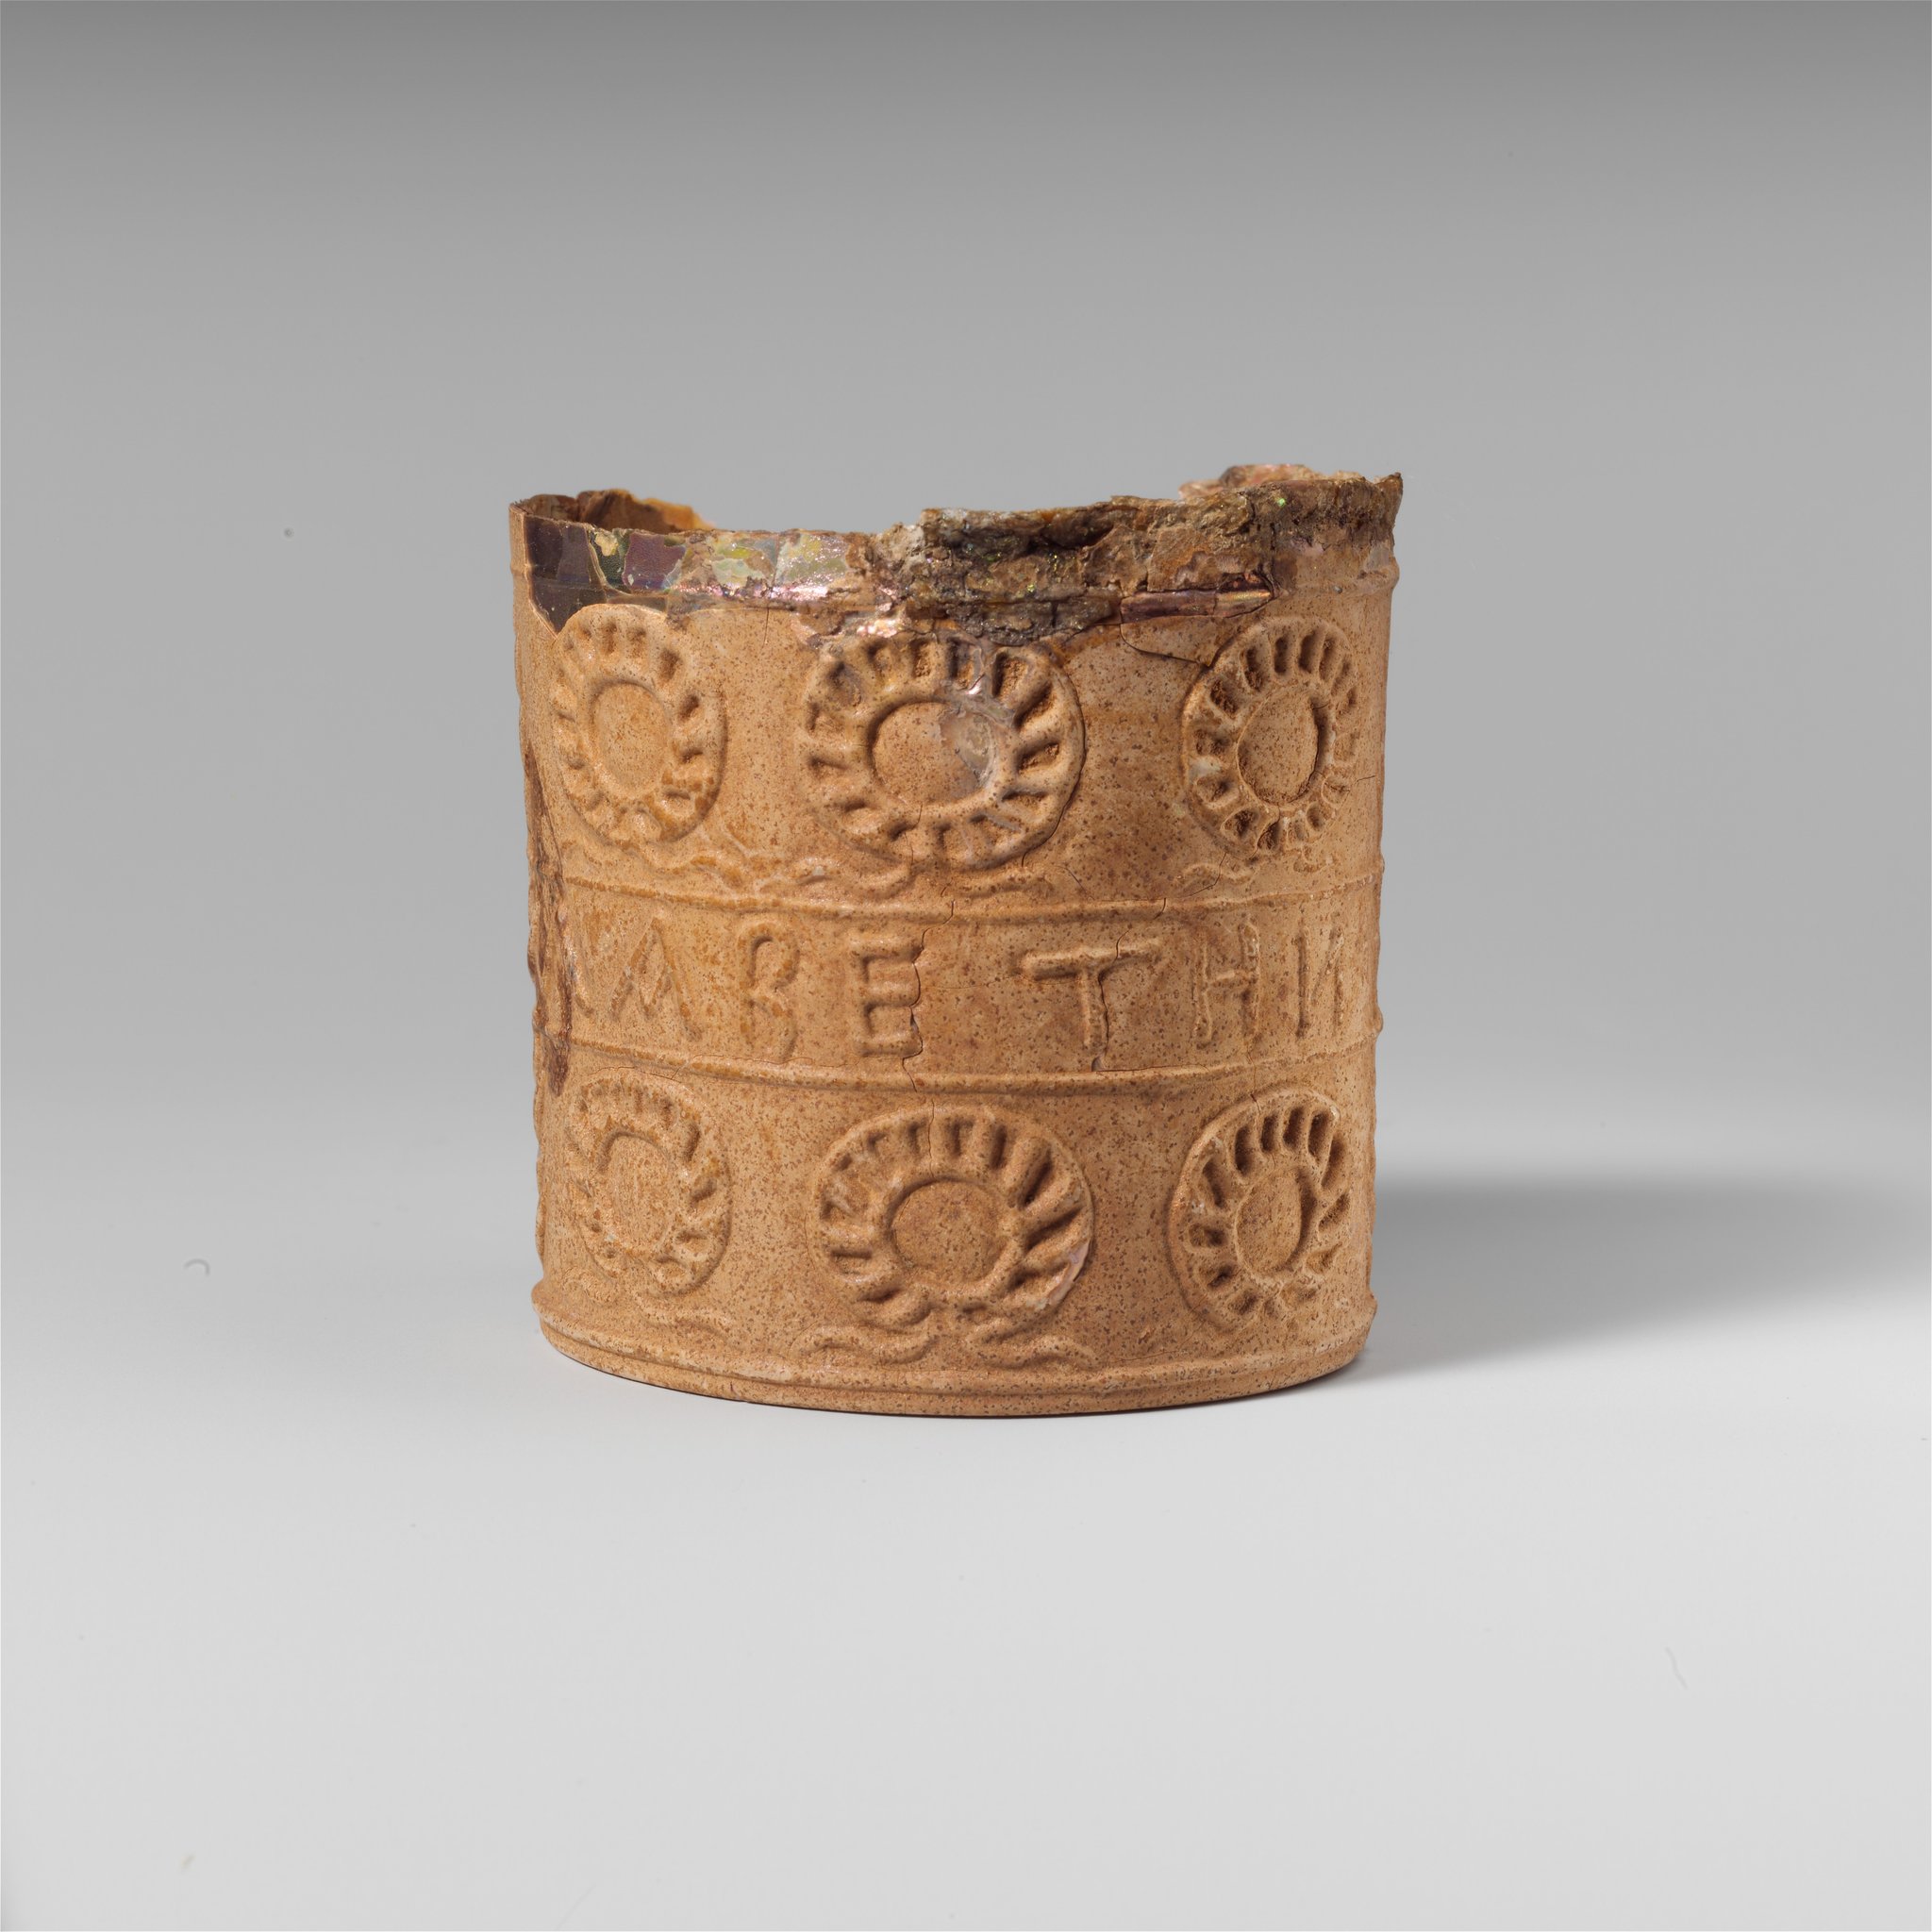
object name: beaker, inscribed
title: Glass beaker with inscription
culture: roman, syrian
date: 1-50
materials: glass